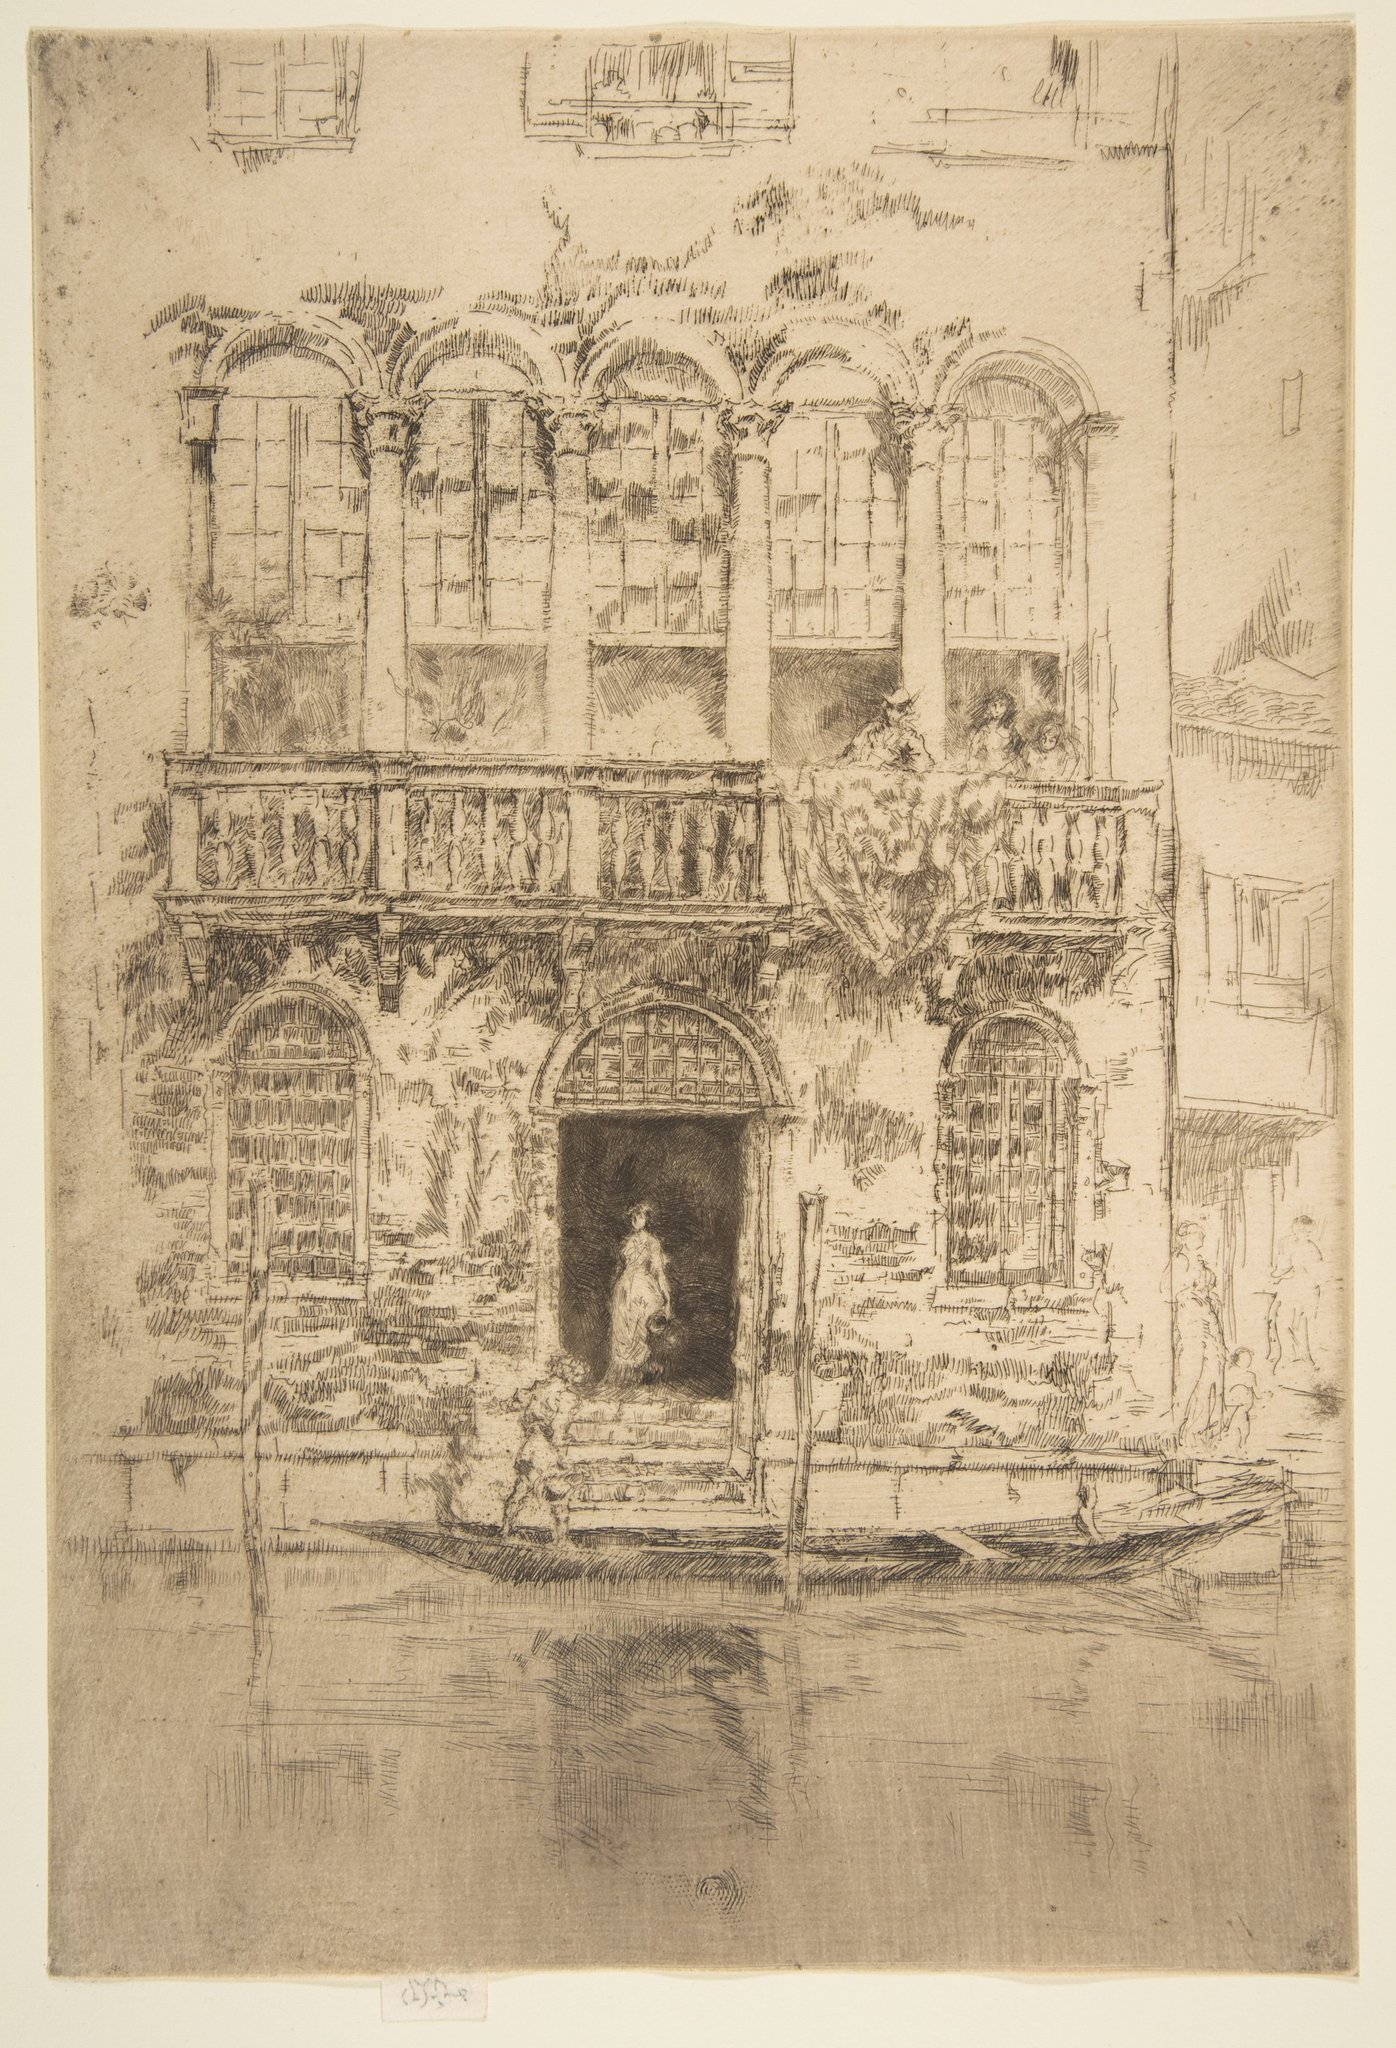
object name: print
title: The Balcony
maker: james mcneill whistler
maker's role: artist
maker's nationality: american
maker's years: 1834-1903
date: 1879-1880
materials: ink, paper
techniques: drypoint, etching, printing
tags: balconies,buildings,boats,venice